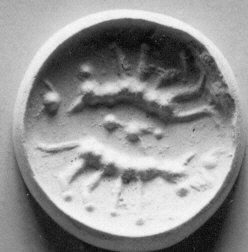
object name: stamp seal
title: Drilled gabled lentoid seal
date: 3500-2900 BCE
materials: stone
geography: iran or mesopotamia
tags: animals